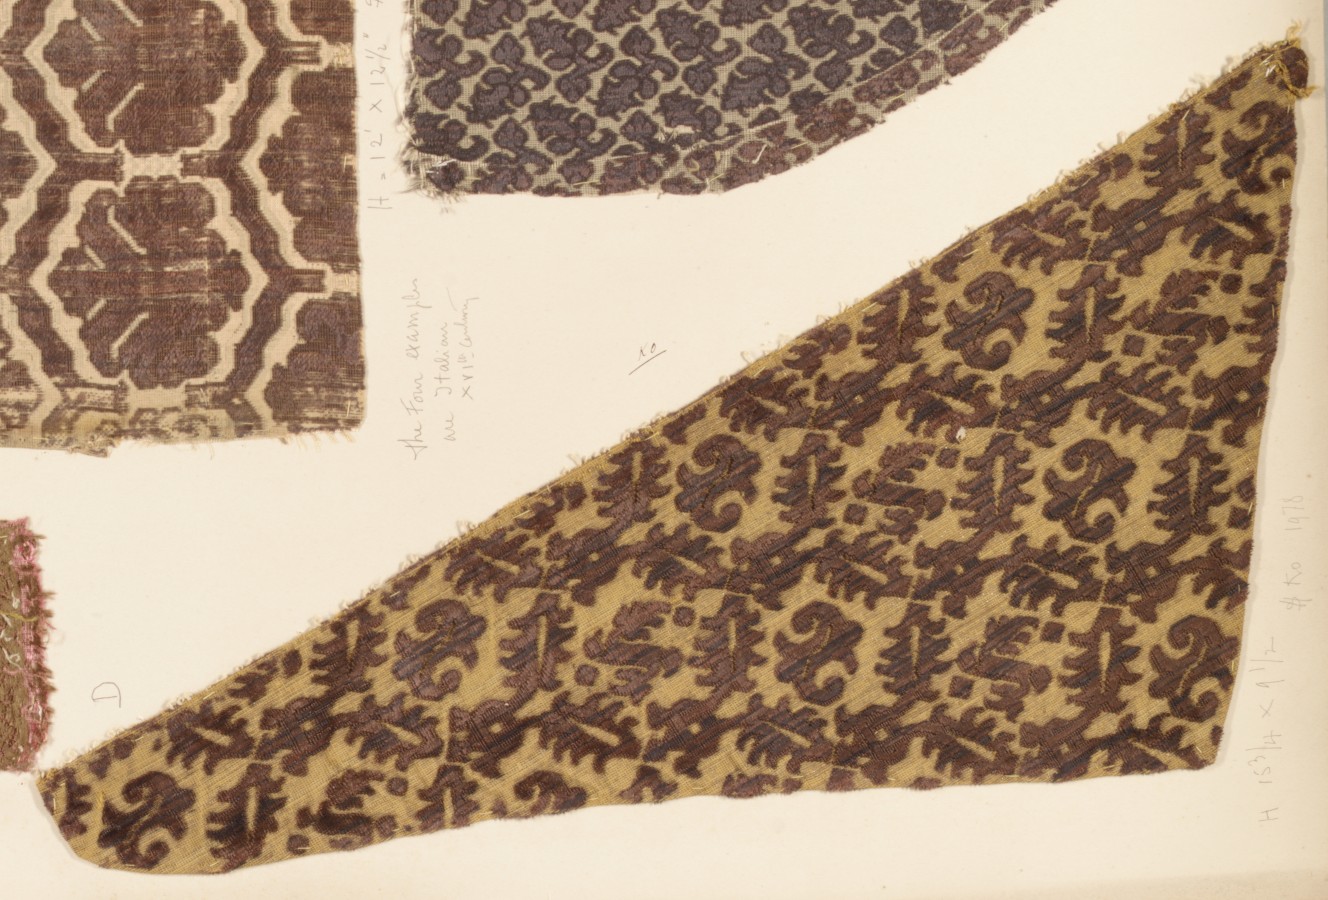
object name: fragment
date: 1501-1600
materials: silk